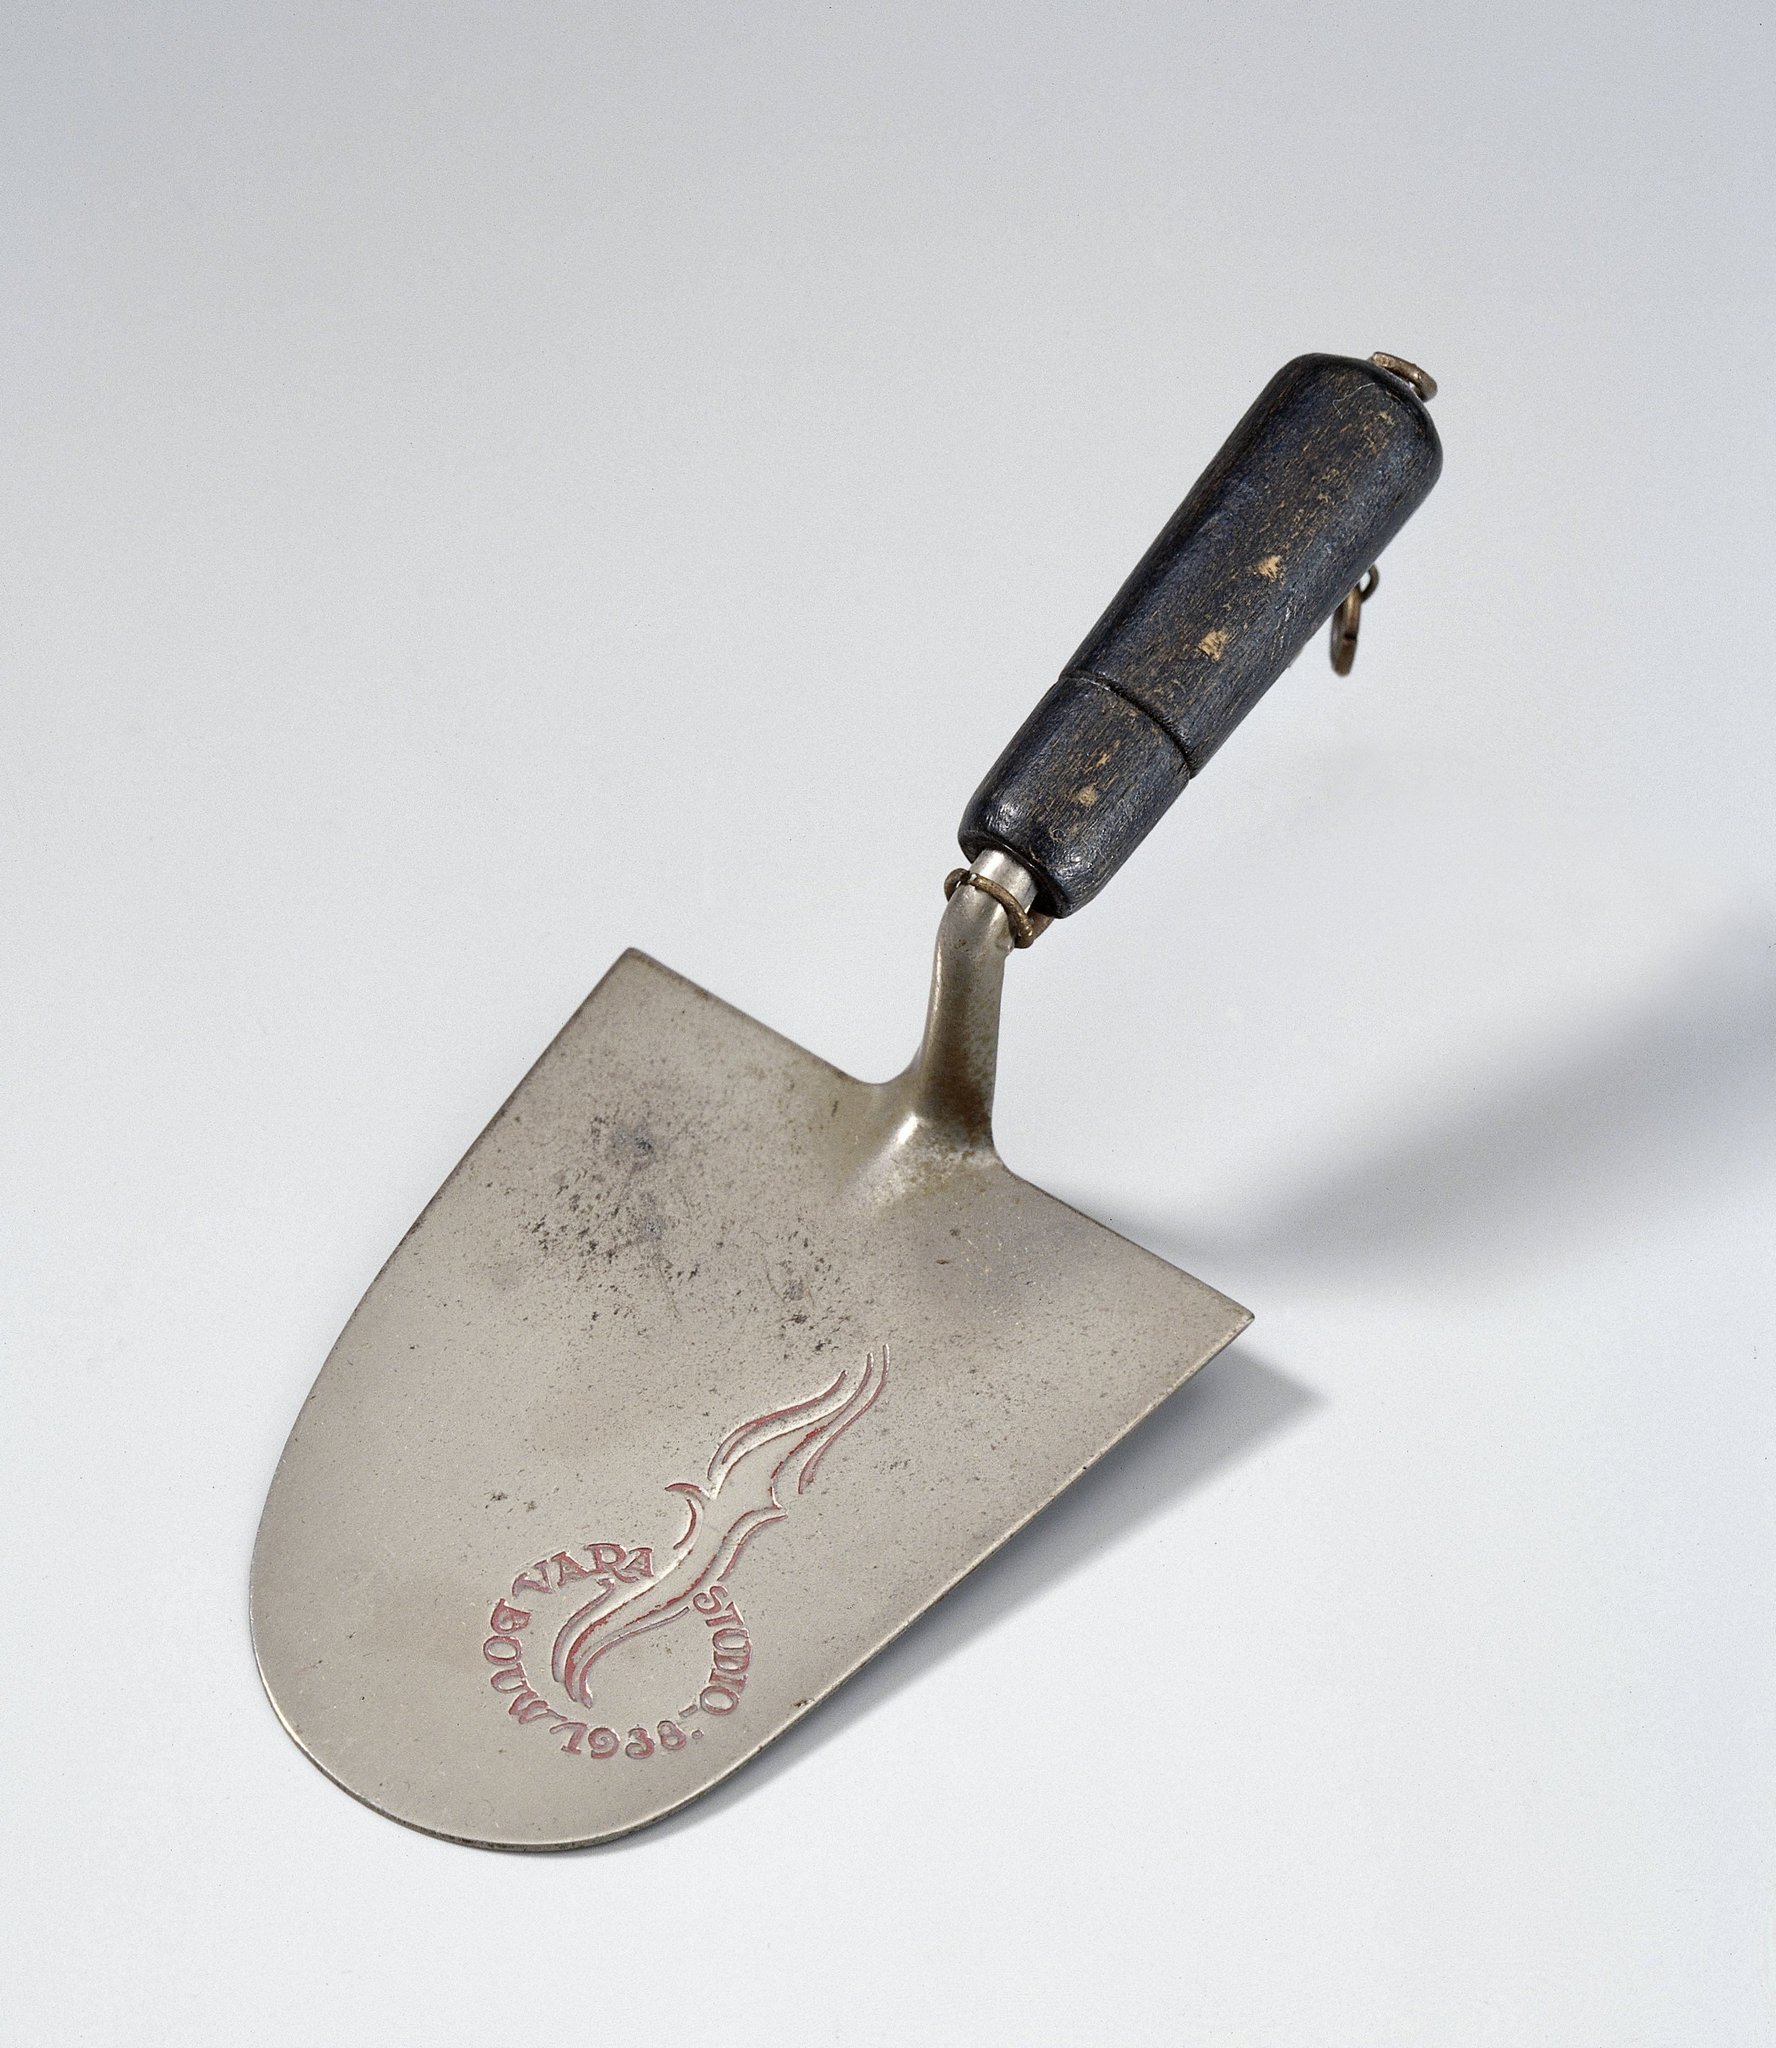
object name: trowel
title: VARA studio bouw 1938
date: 1938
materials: metal, wood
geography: netherlands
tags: vara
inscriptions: inscription: ‘VARA STUDIO BOUW 1938’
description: In the 1920s the various Dutch religious and political streams established separate radio organisations. The Protestant NCRV started in 1924, the Catholic KRO and the Socialist VARA in 1925, the Nonconformist Protestant VPRO in 1926 and the Liberal AVRO in 1927. All these organisations had one thing in common: lack of funds. There were constant money-raising activities and membership drives.